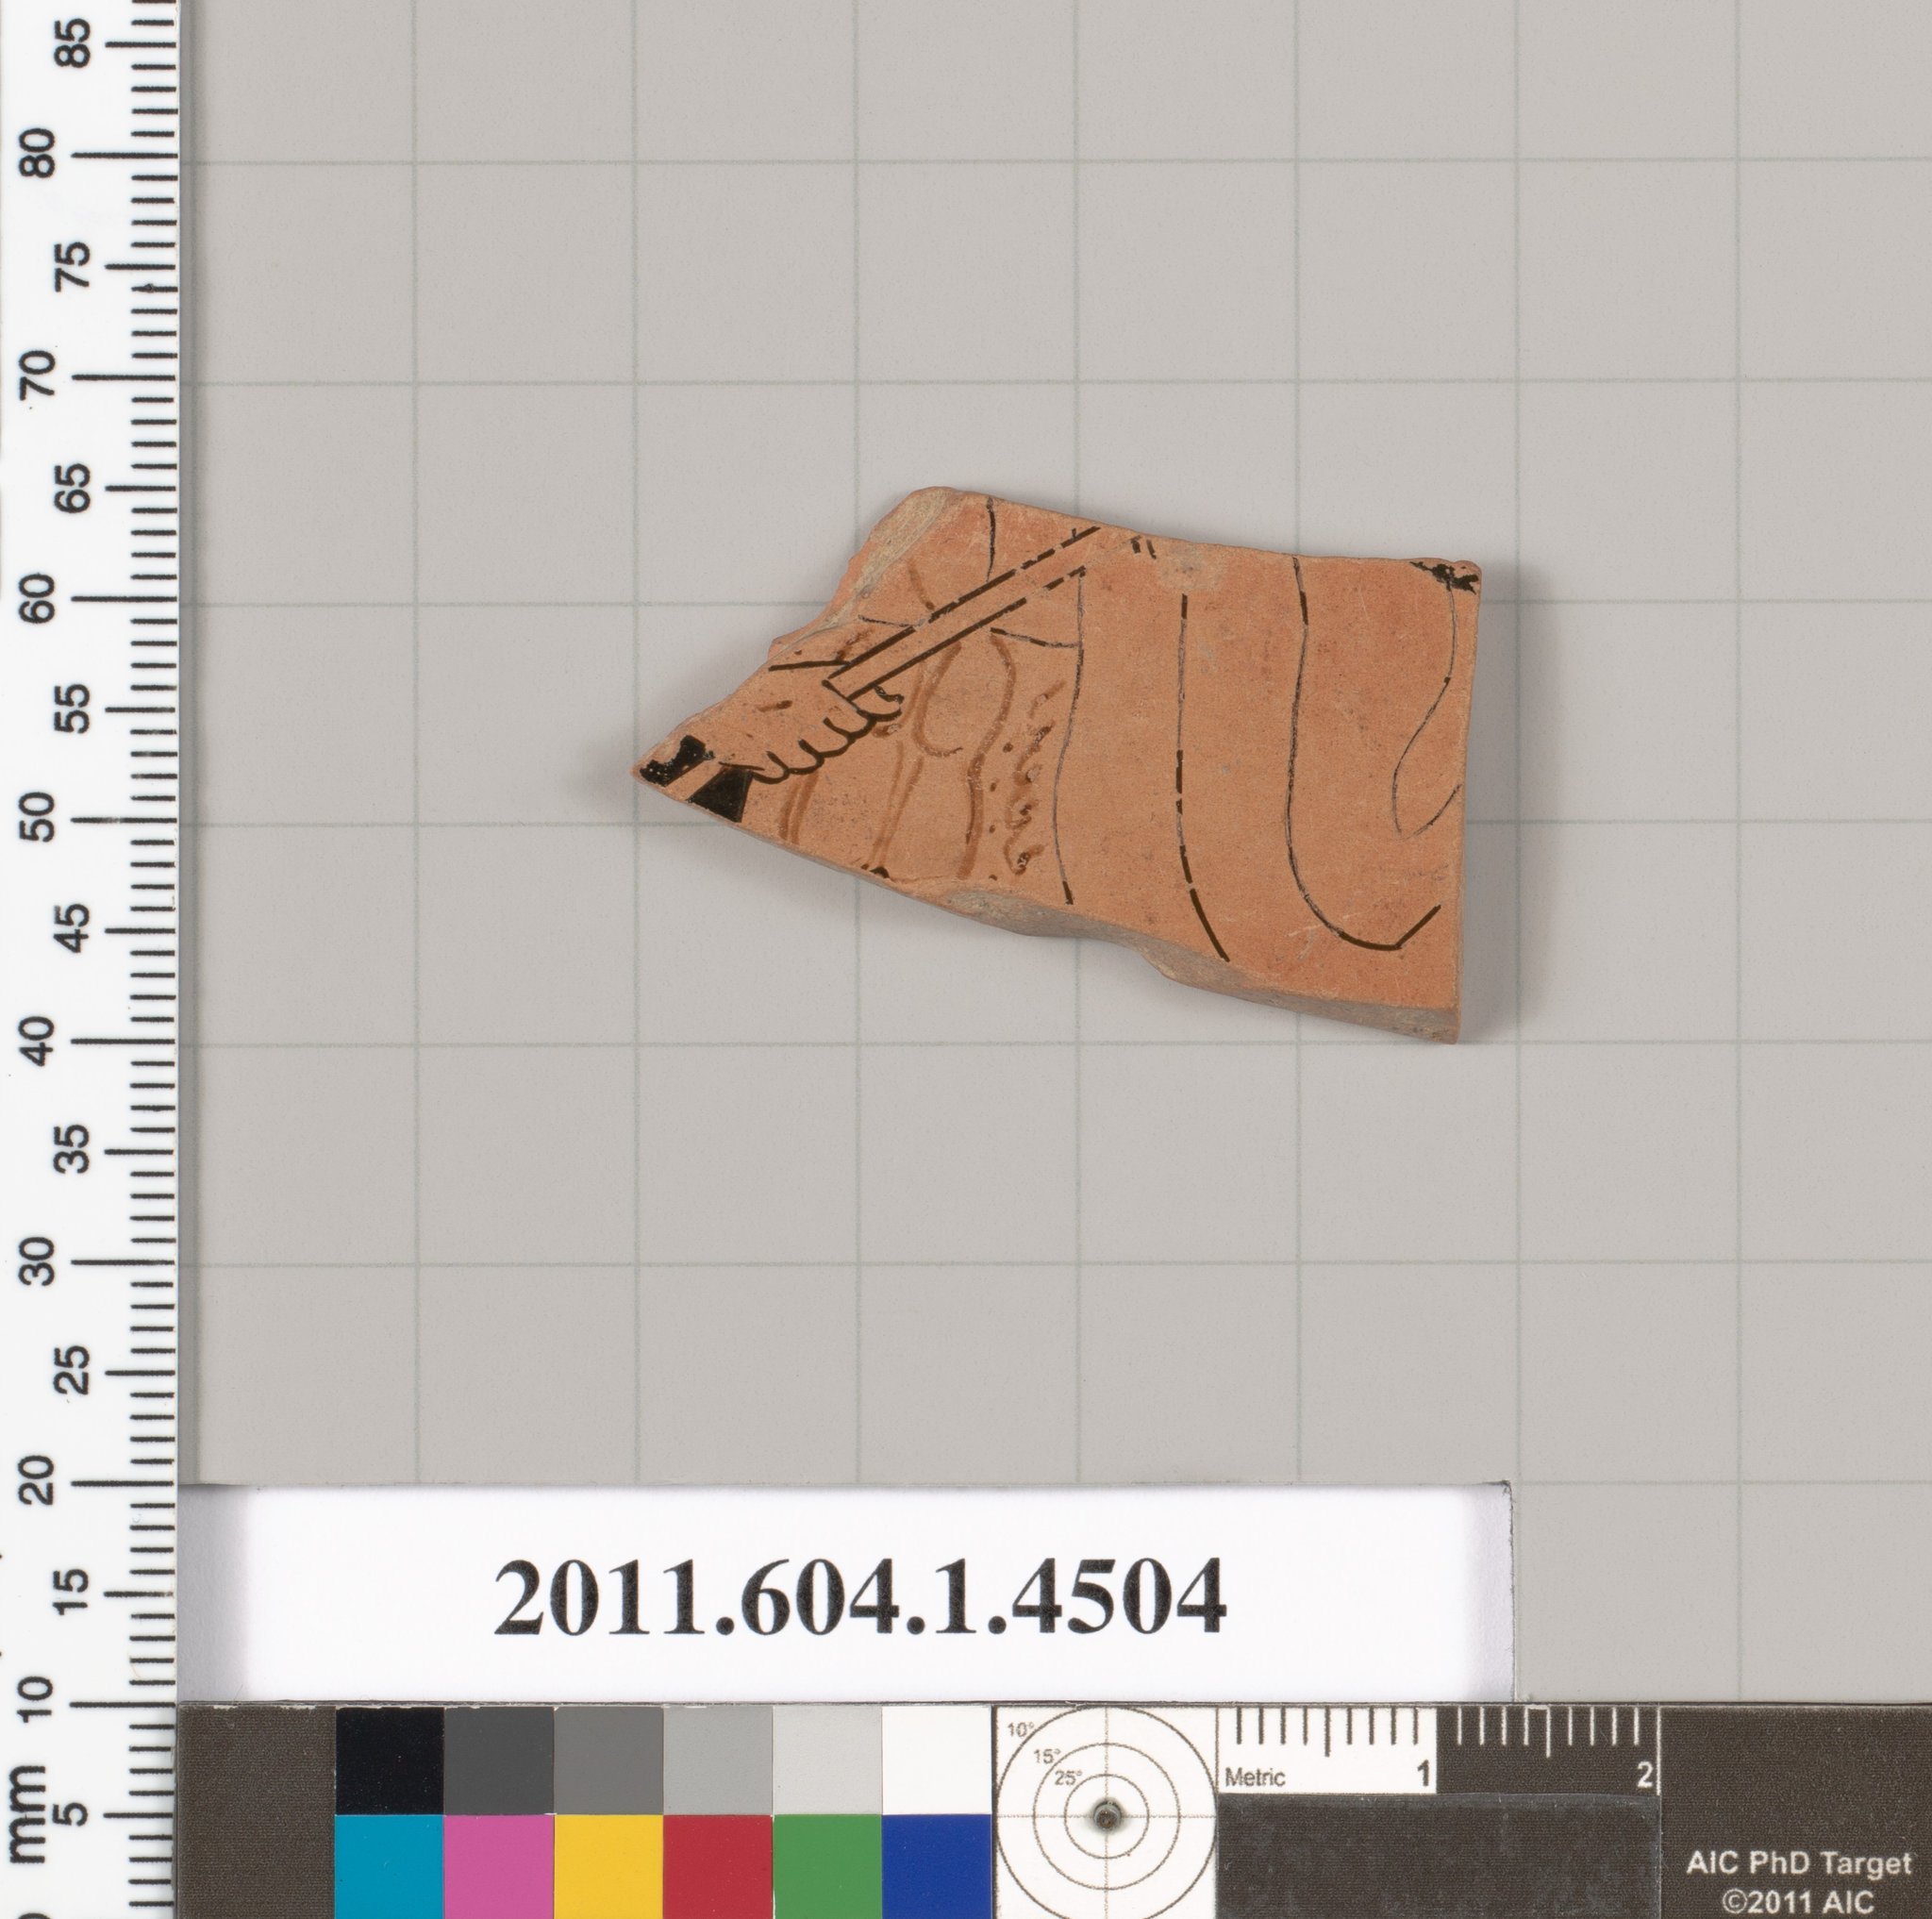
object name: kylix fragment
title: Terracotta fragment of a kylix (drinking cup)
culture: greek, attic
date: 480-470 BCE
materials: terracotta